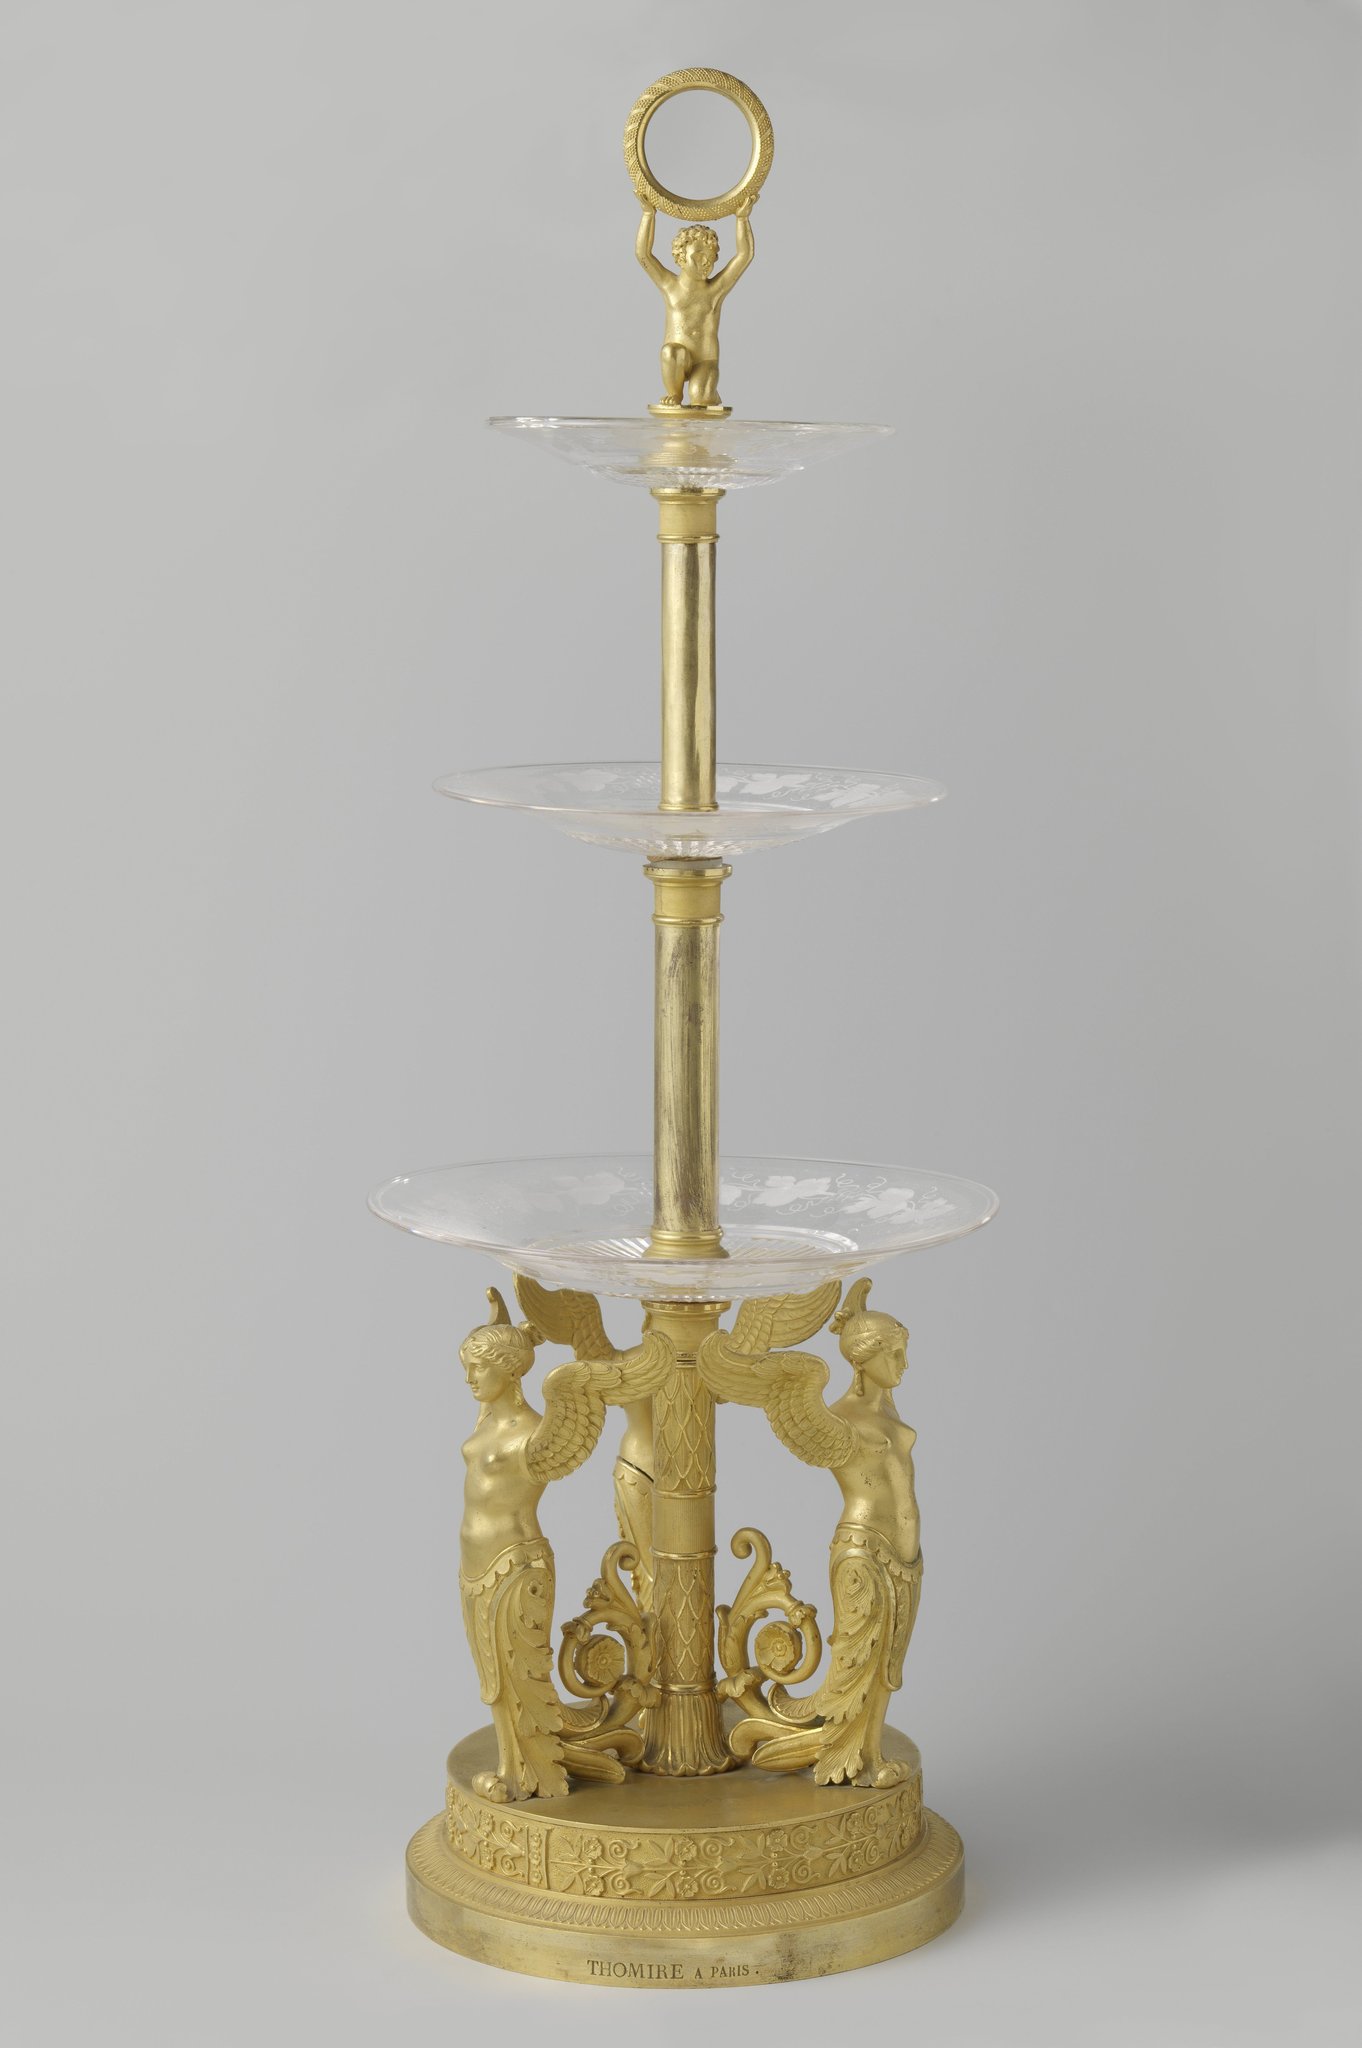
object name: eating drinking utensil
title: Tafelstuk van verguld brons en geslepen kristal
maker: pierre philippe thomire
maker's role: brazier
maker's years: 1751-1843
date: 1805-1815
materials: bronze, crystal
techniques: gilding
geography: paris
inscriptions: signature: ‘THOMIRE A PARIS’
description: Tafelstuk van verguld brons en geslepen kristal. De voet is versierd met bladwerk en rozetten. Op een dekplaat staan drie afgewende gevleugelde vrouwenfiguren, oprijzend uit acanthusgebladerte en eindigend in bladranken met rozetten. De stam heeft een basis van bladeren en is bewerkt met puntig bladwerk, waarboven een kapiteel. De stam draagt drie kristallen schaaltjes van opeenvolgend formaat, versierd met wingerdranken en gescheiden door twee gladde zuilen. Bovenop een geknielde putto met krans.